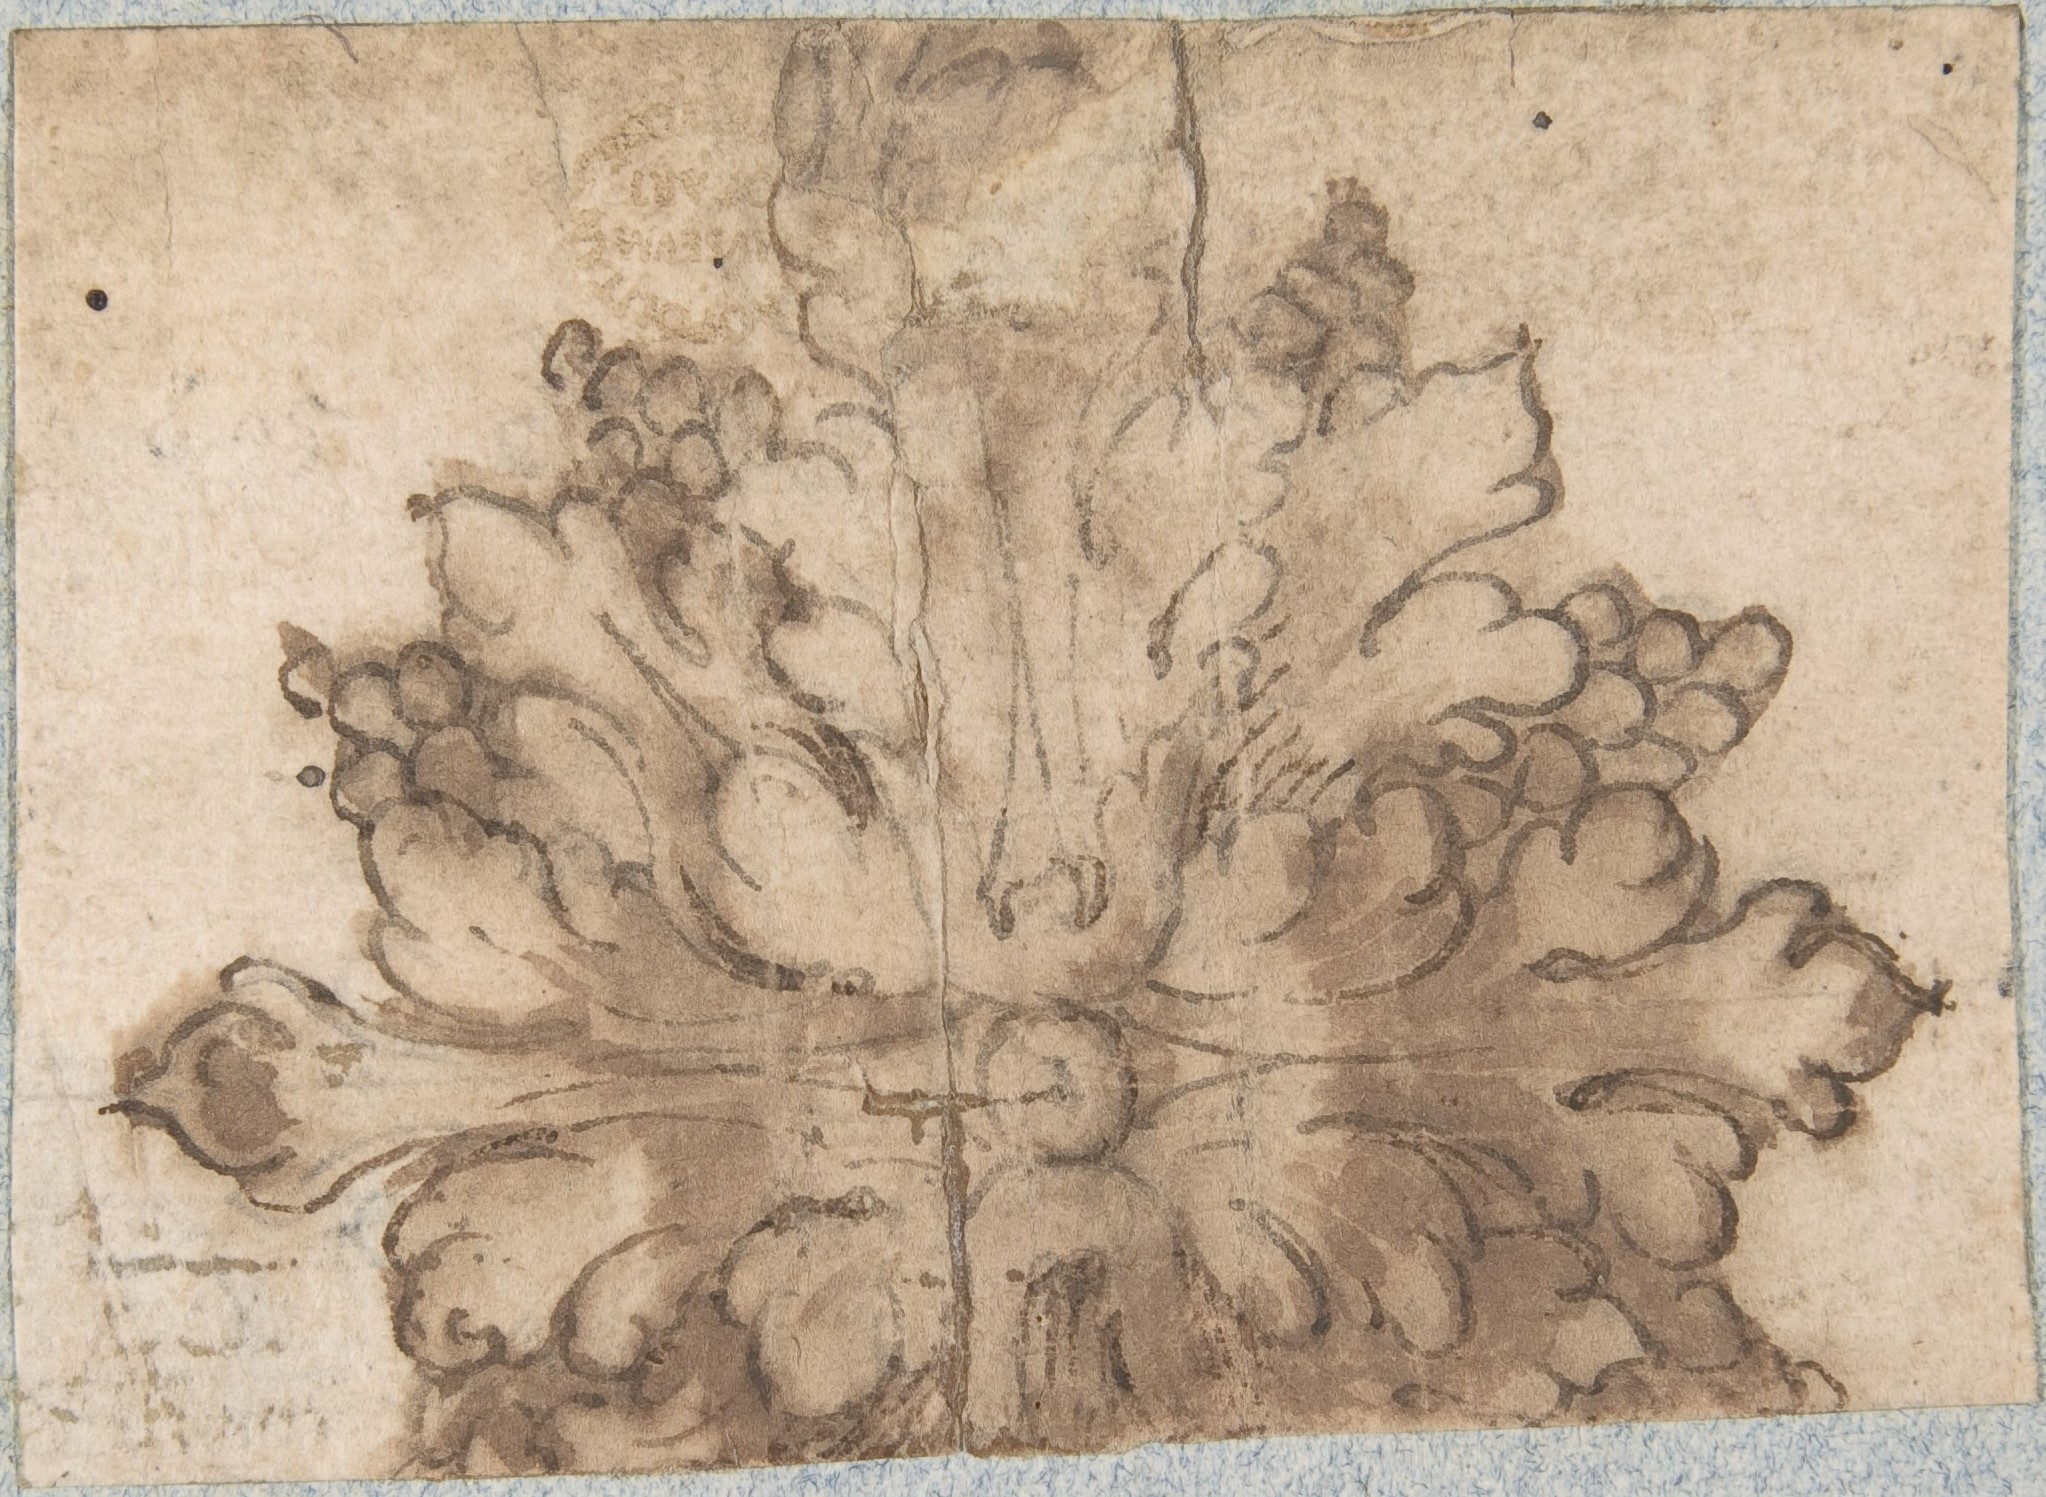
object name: drawing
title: Architectural Detail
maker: anonymous, italian, 16th century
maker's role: artist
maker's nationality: italian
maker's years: 1550-1600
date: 1501-1600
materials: ink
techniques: pen, wash